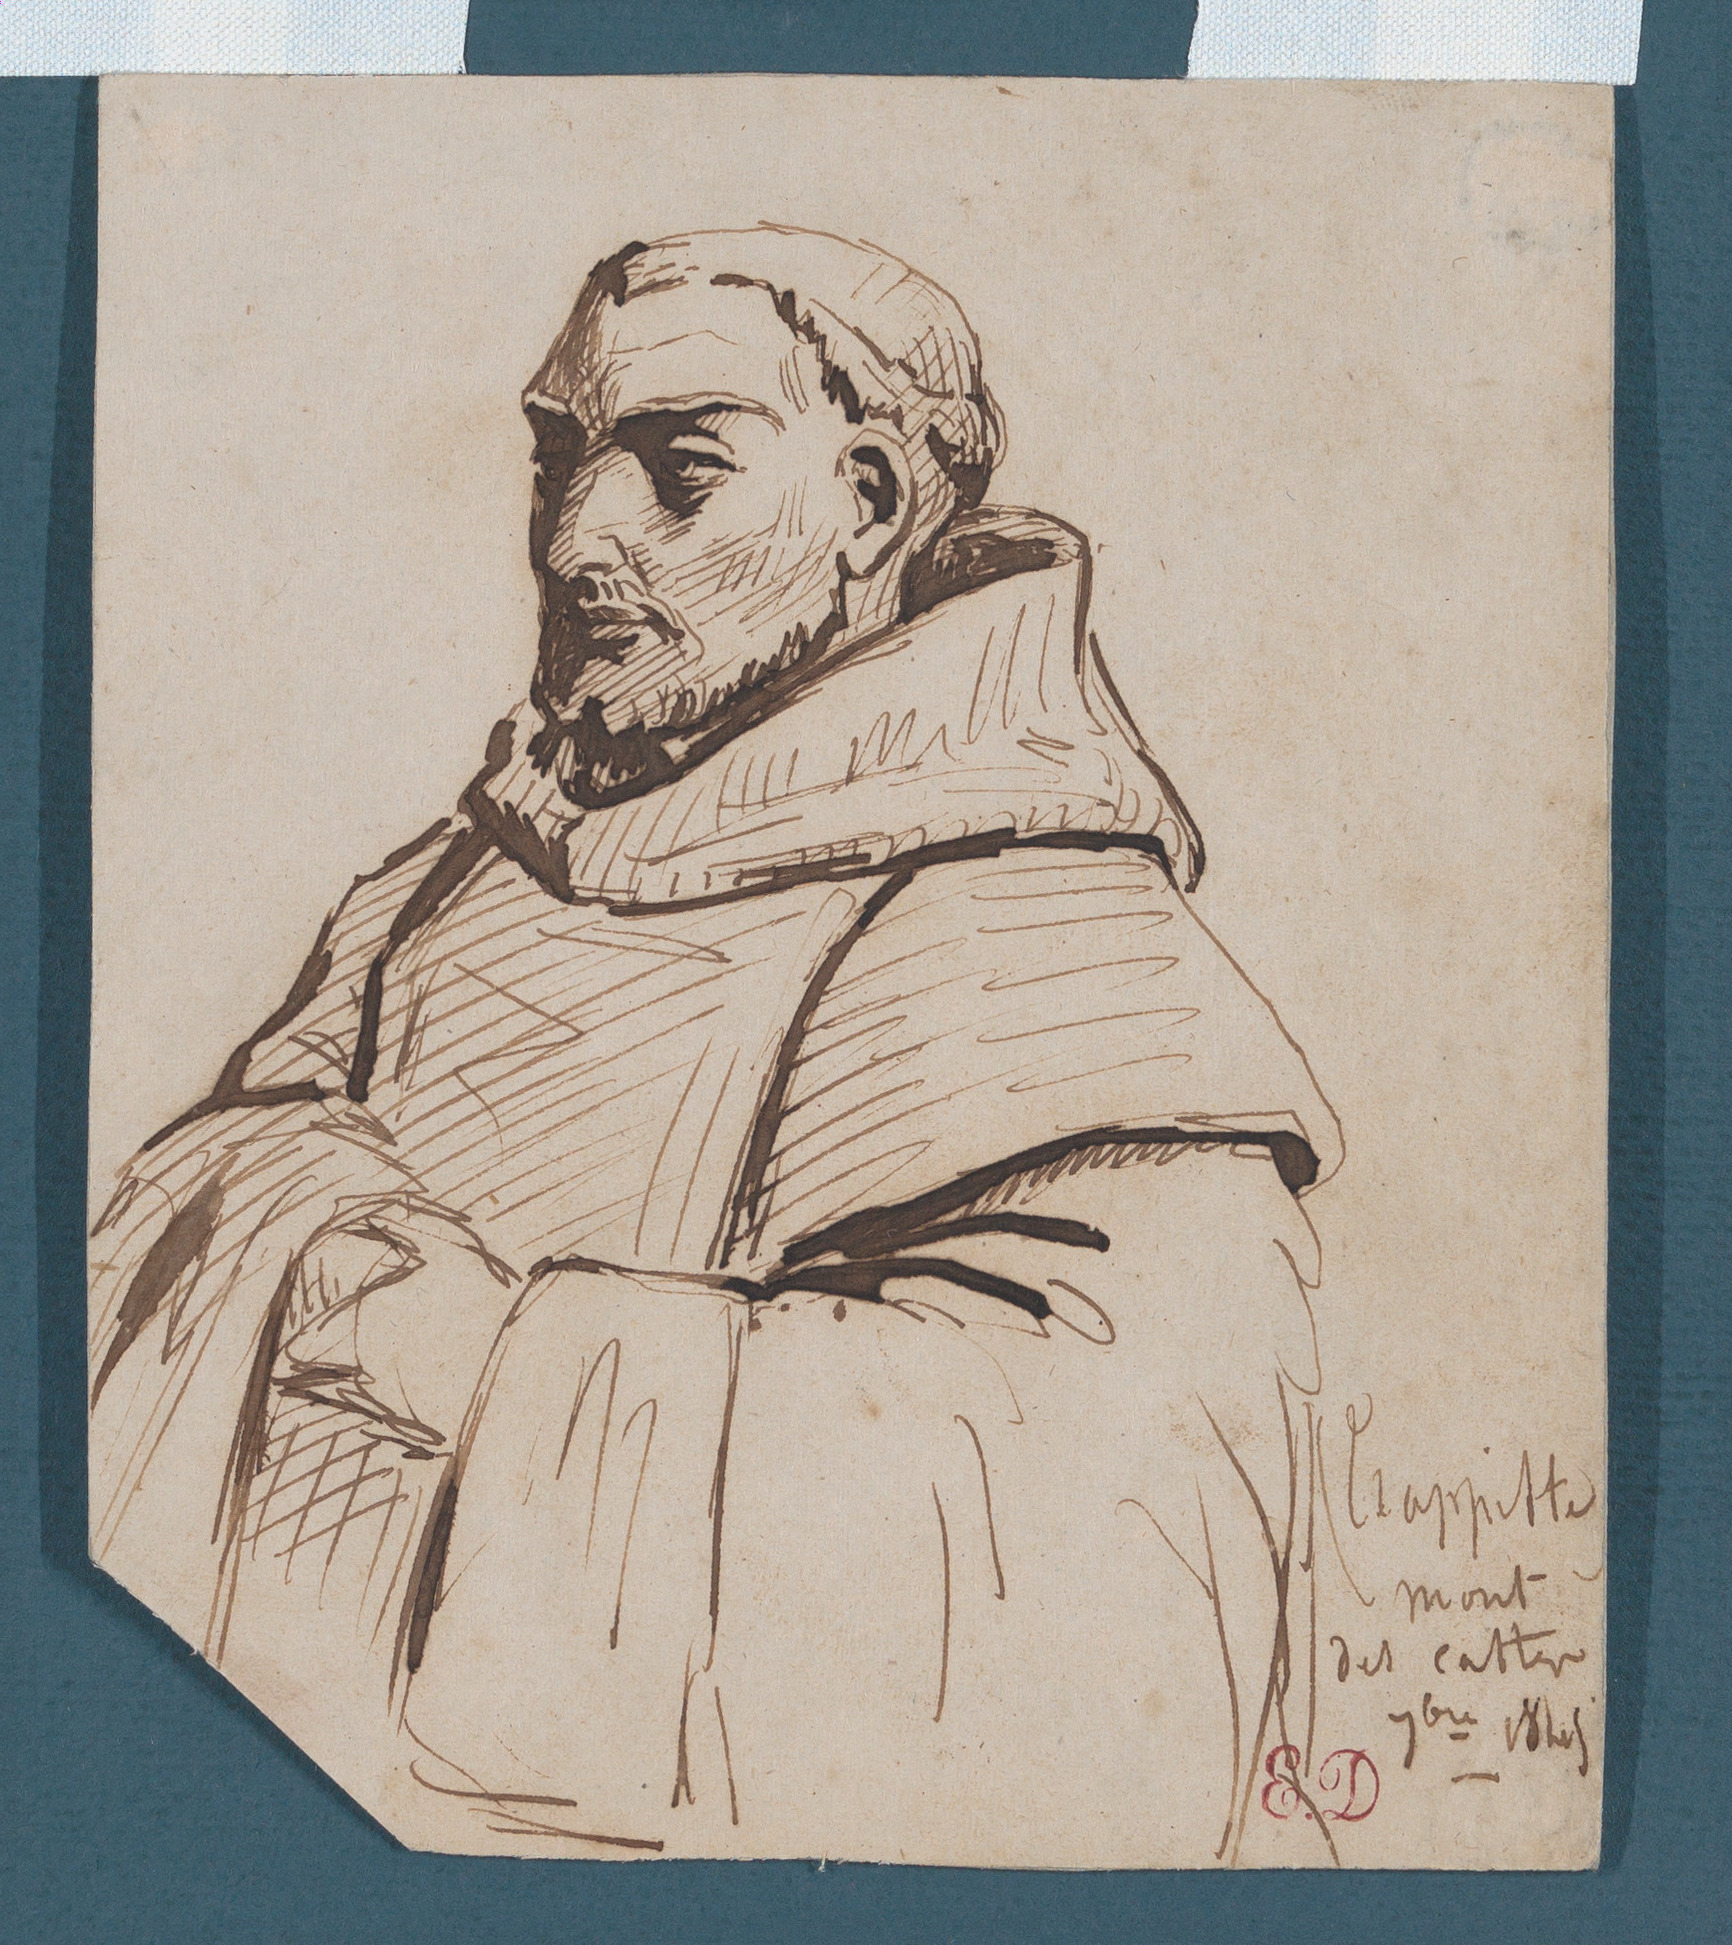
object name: drawing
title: Portrait of a Trappist Monk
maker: eugène delacroix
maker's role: artist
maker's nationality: french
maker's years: 1798-1863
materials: ink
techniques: pen